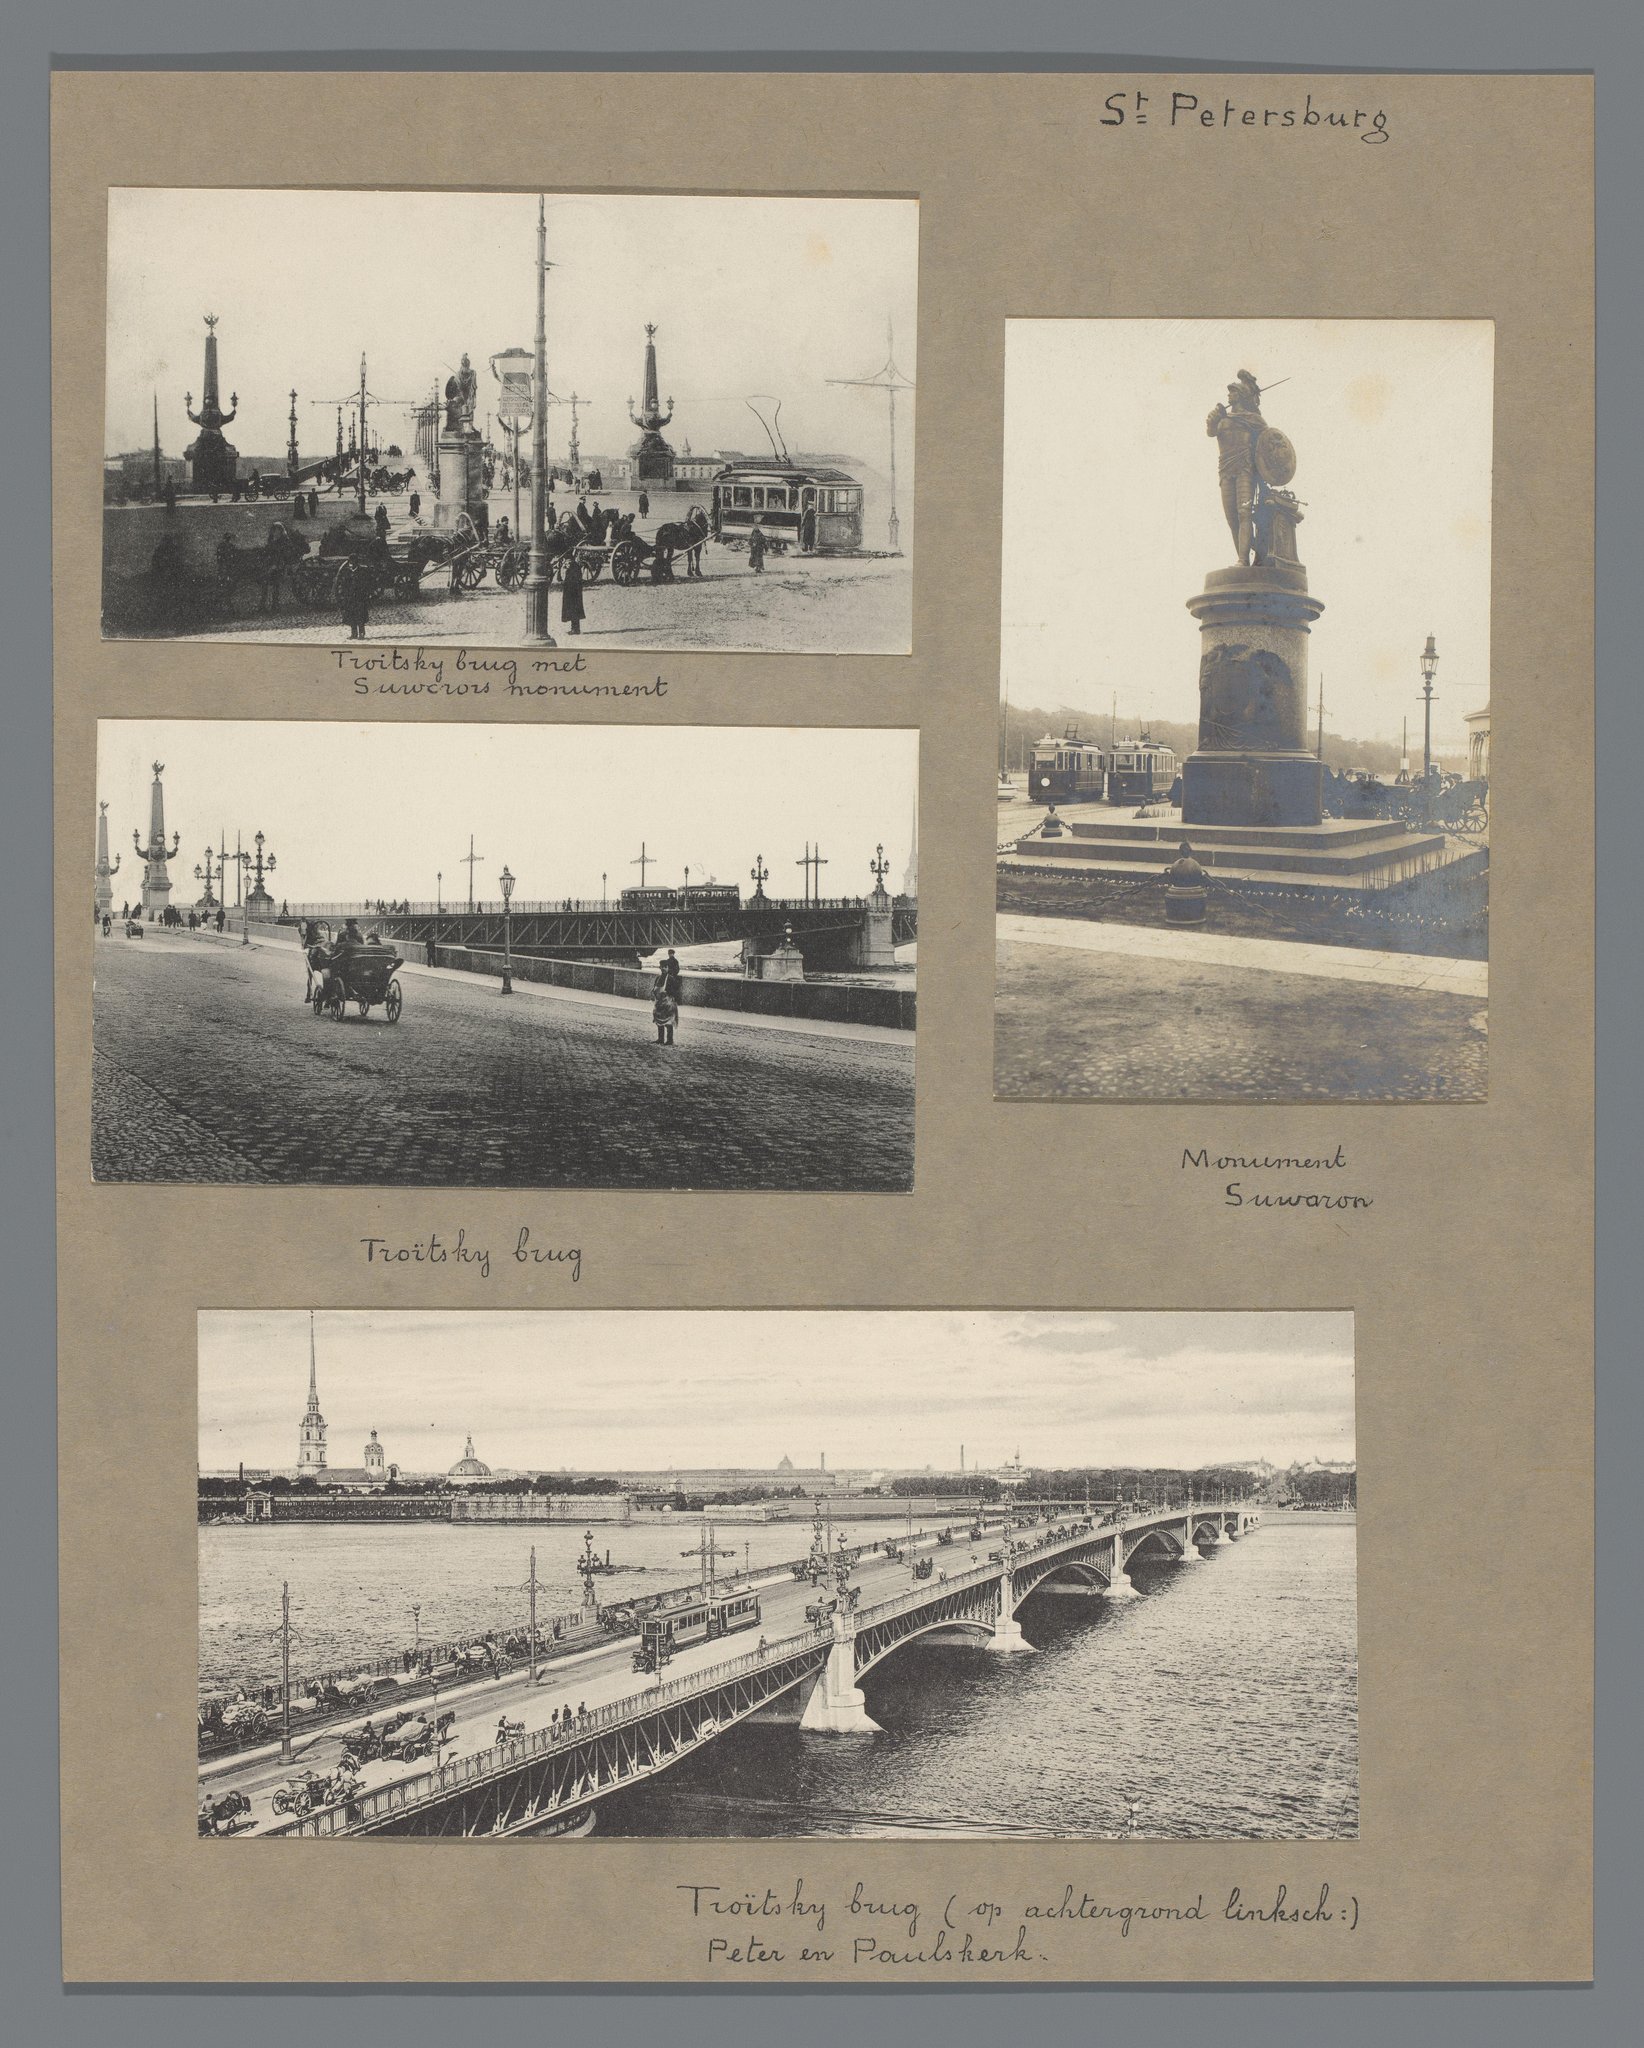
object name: photograph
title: St. Petersburg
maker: Anonymous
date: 1860-1925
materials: photographic support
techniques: photograph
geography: russia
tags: sint-petersburg